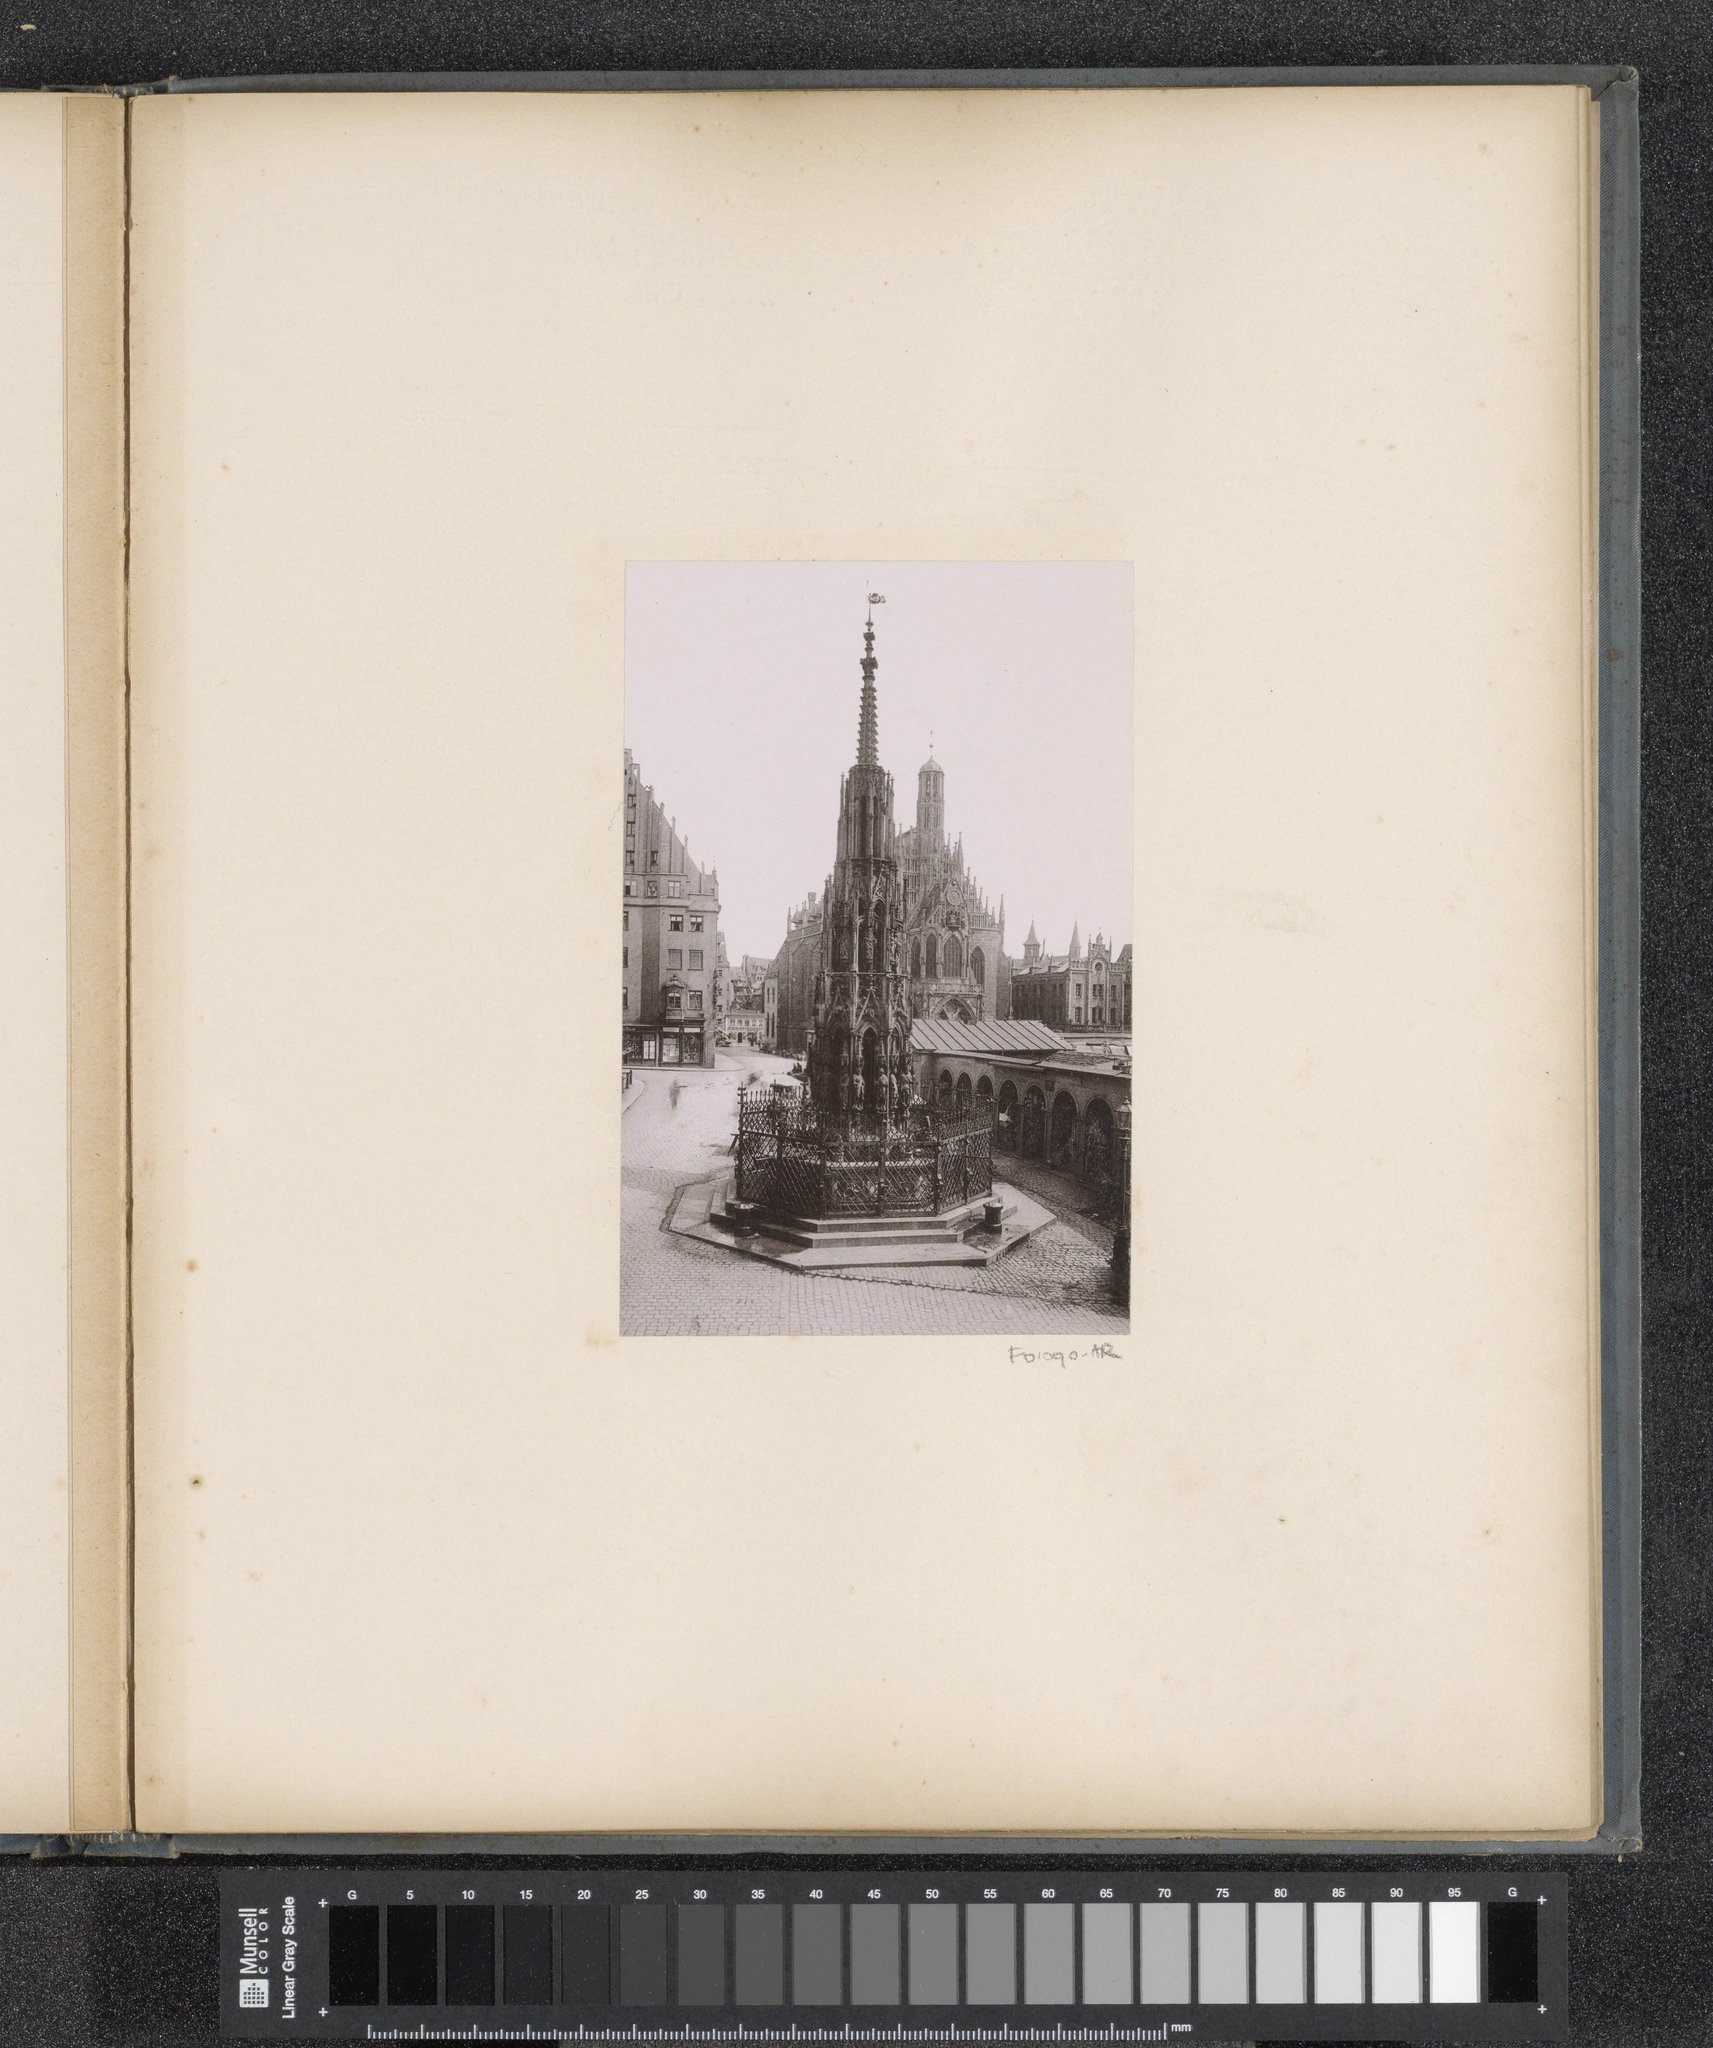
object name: photograph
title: Schöner Brunnen in Neurenberg met op de achtergrond de Onze-Lieve-Vrouwekerk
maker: Anonymous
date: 1870-1900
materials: paper, photographic support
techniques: photograph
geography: nuremberg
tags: church (exterior), utilitarian, public pump or water fountain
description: Onderdeel van Reisalbum met foto's van bezienswaardigheden in Duitsland en Oostenrijk en van kunstwerken.